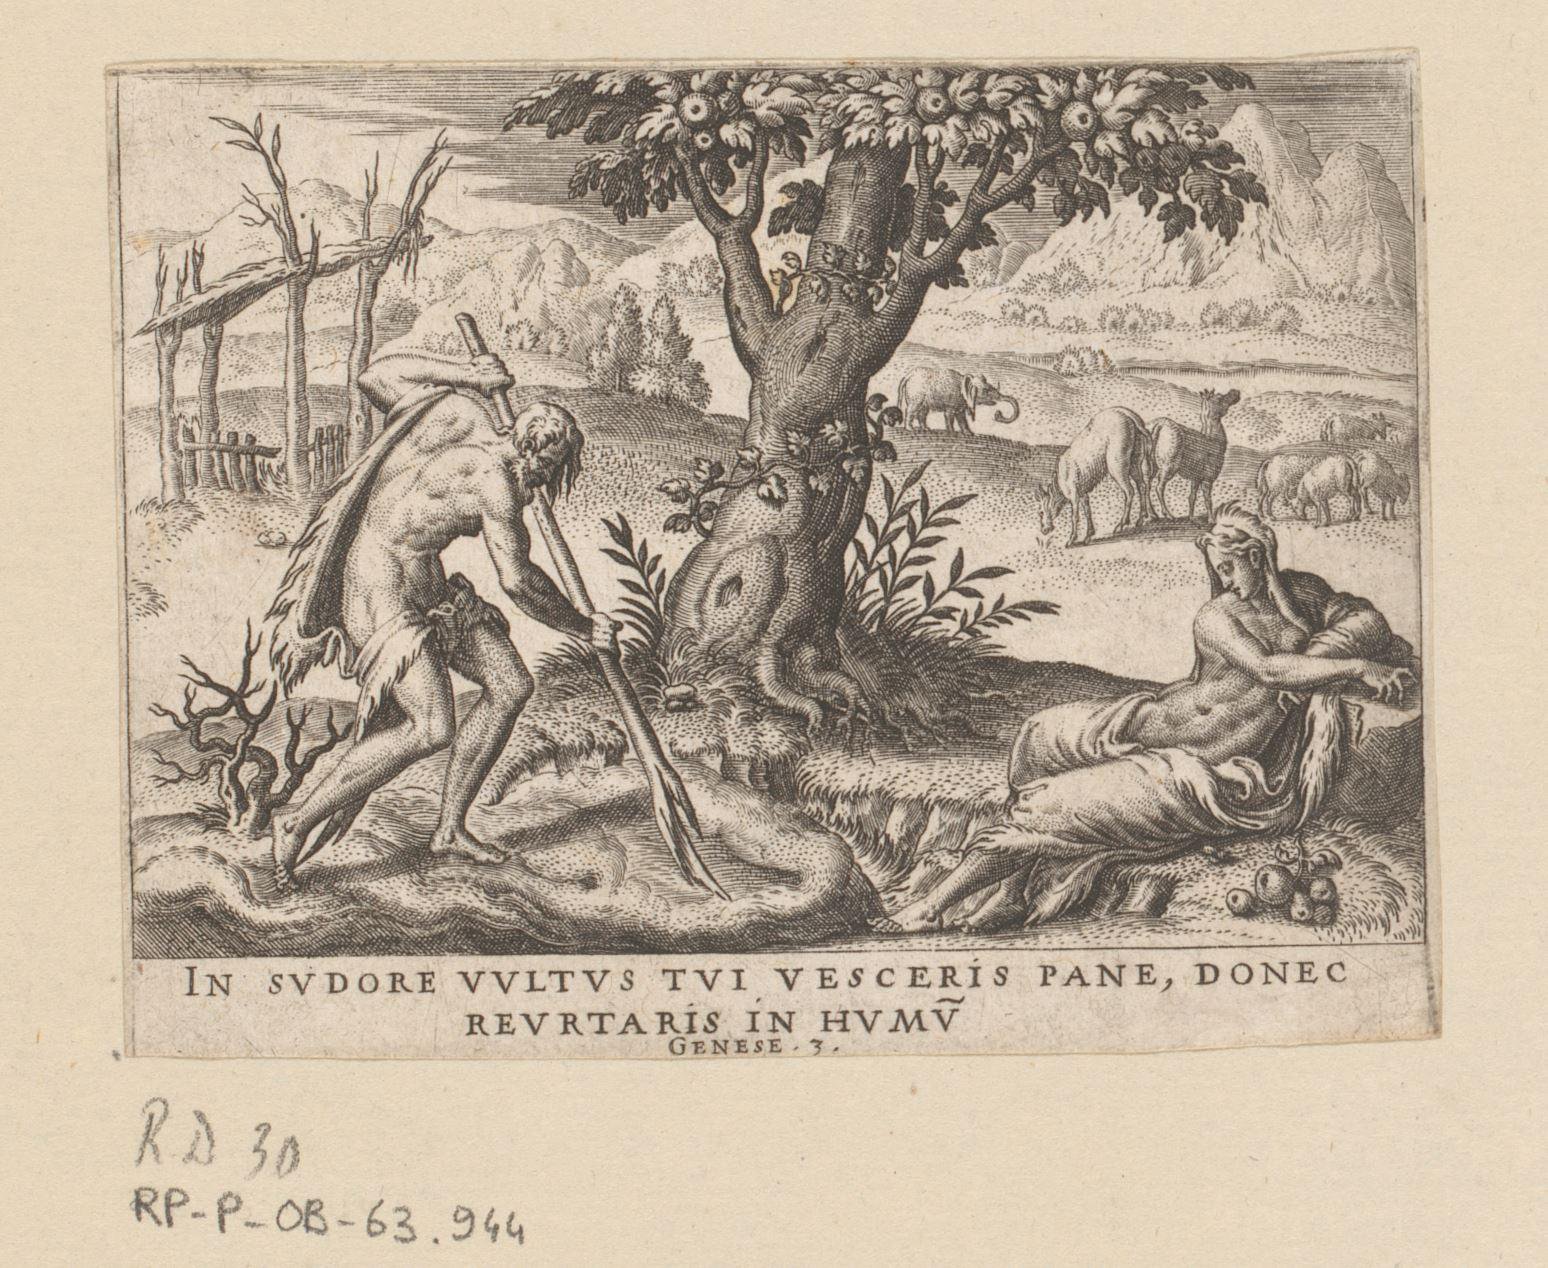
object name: print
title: Histoire de la Genèse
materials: paper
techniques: engraving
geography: france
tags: the labours of adam and eve; infancy of cain and abel (genesis 4:1-2)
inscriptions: collector's mark: Lugt 240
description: Maakt deel uit van een serie met mogelijk kopieën naar prenten door Etienne Delaune met illustraties bij de Genesis.